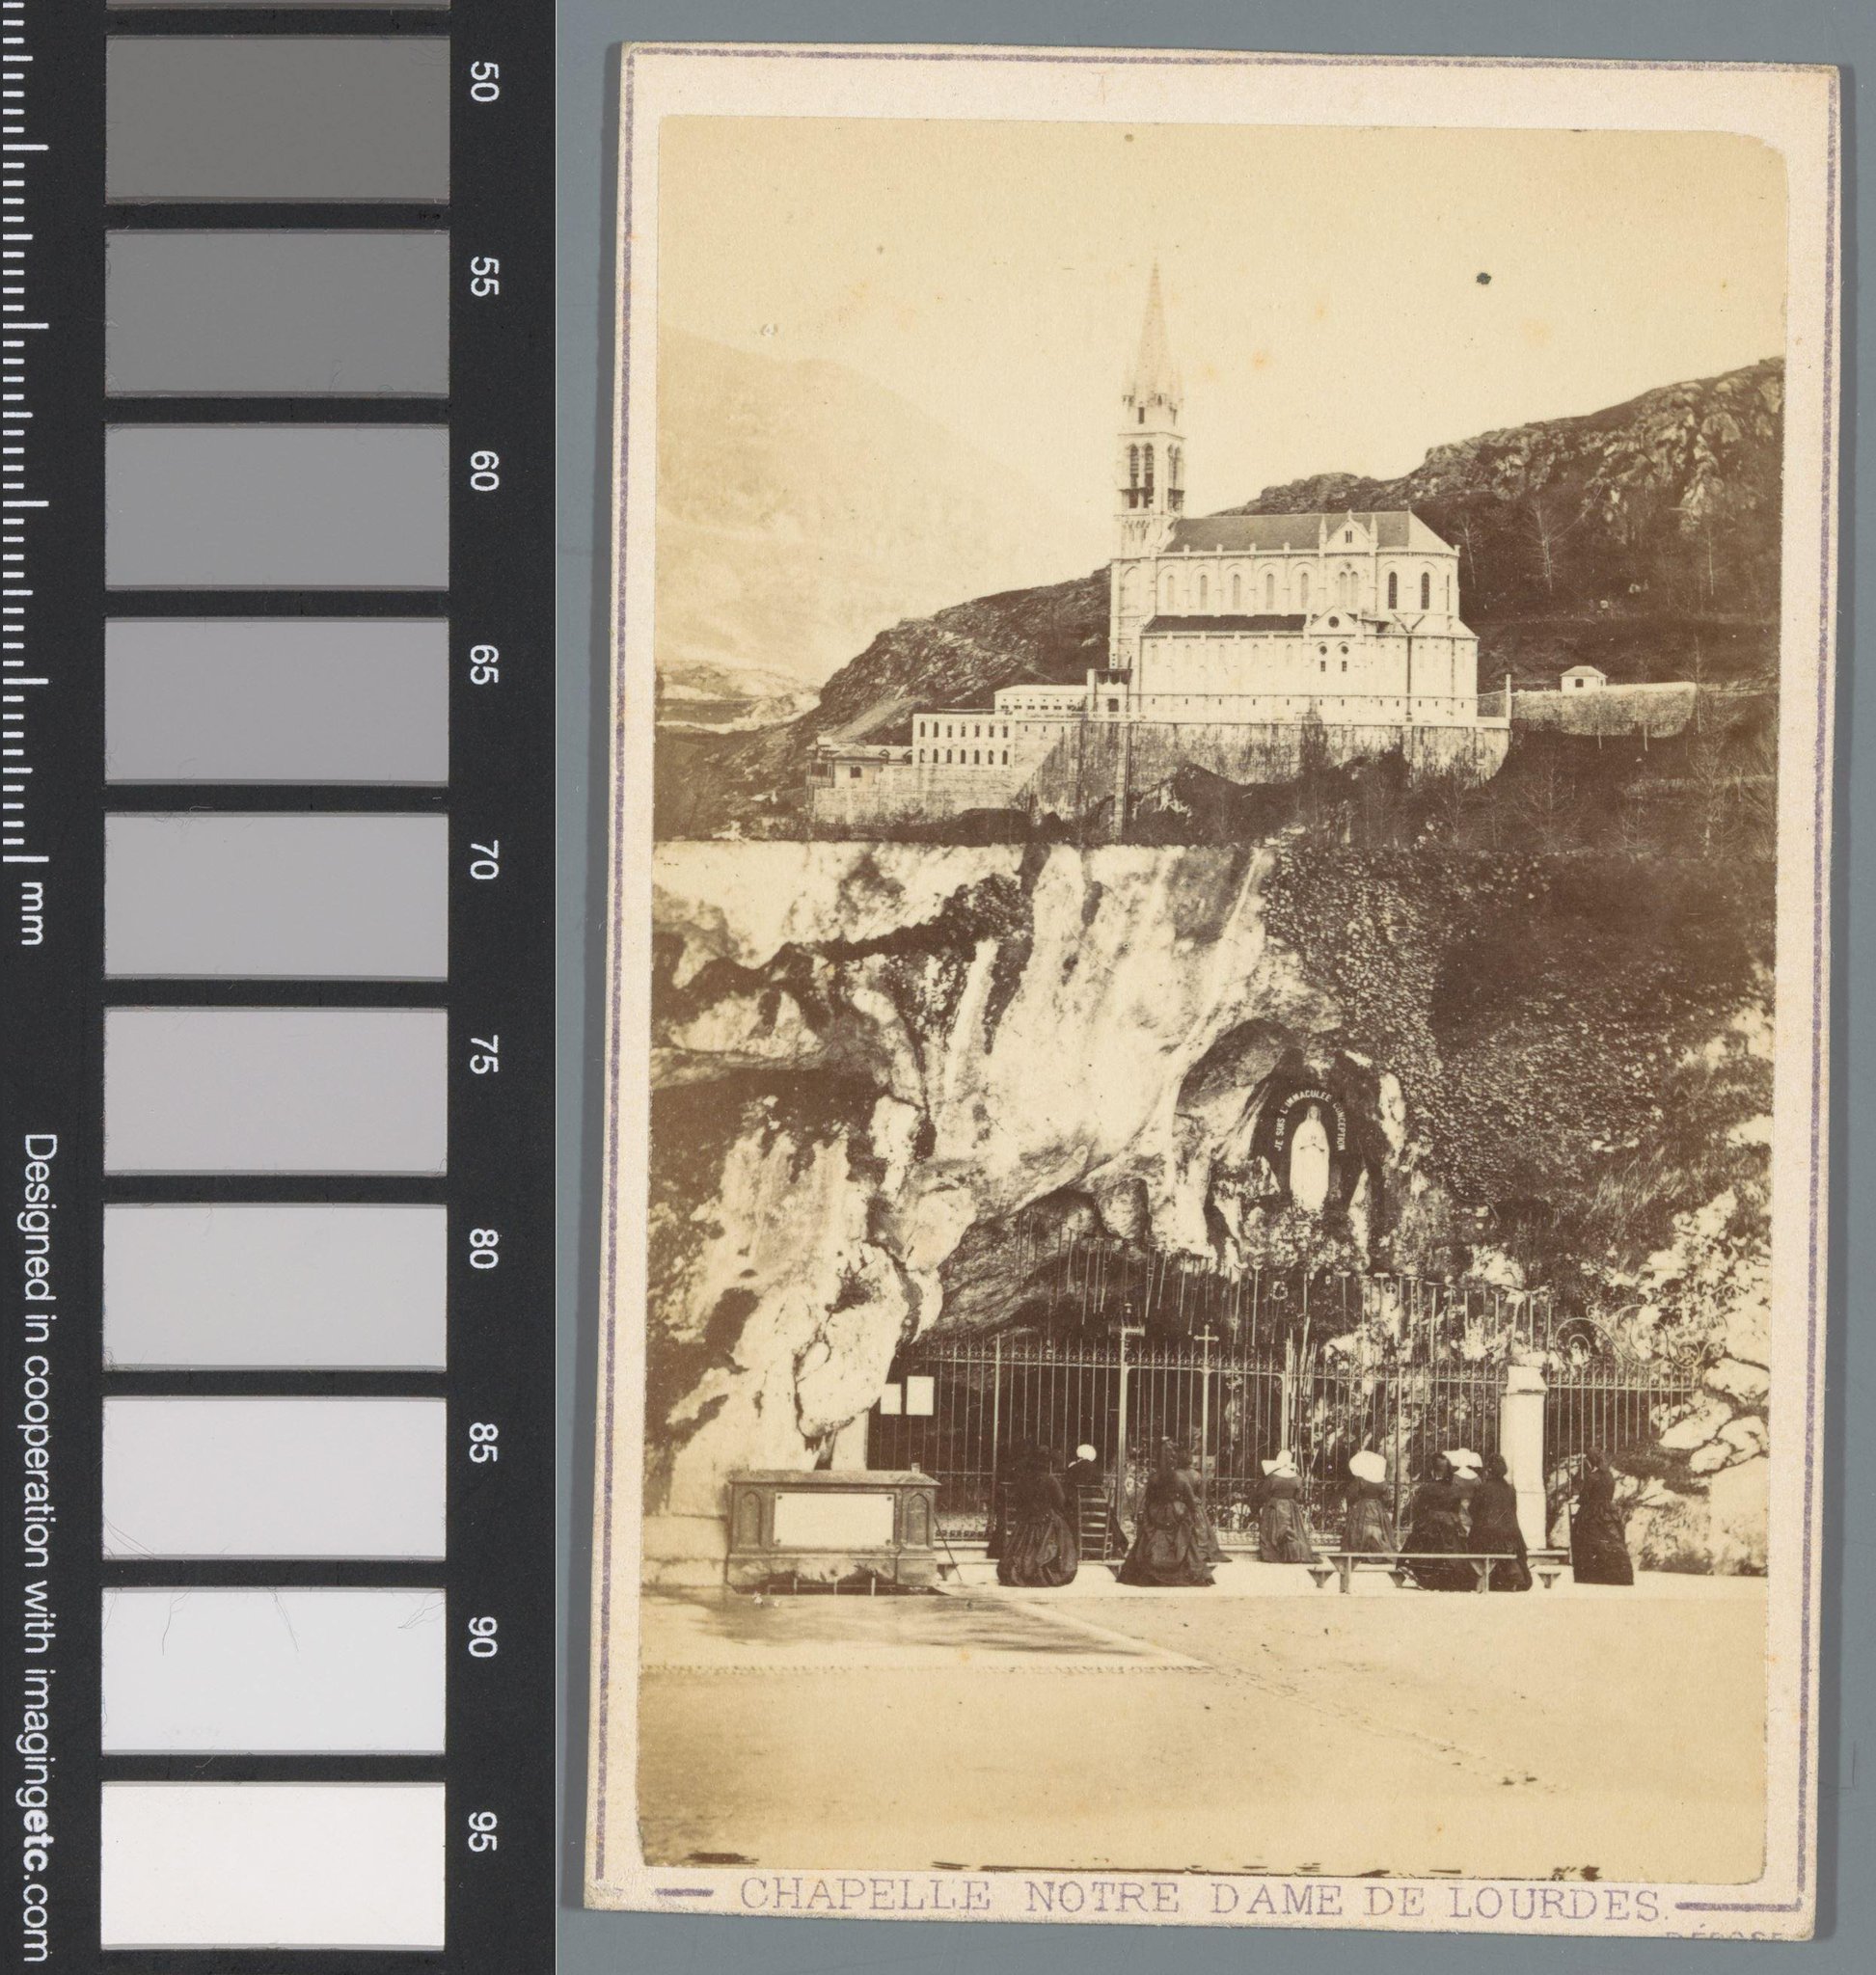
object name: carte de visite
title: Chapelle Notre Dame de Lourdes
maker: p. viron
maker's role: fotograaf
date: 1872-1880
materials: cardboard, paper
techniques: albumen print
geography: lourdes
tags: church (exterior), cave, grotto, pilgrim(s) at destination-point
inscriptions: inscription: ‘PHOTOGRAPHIE VIRON À LOURDES/ PRIÈRE A NOTRE-DAME DE LOURDES/ (...)/ A.N.~D de Poueylaün en tournée/ pastorale, le 4 Mai 1872./ P. A. Ev. de Tarbes’